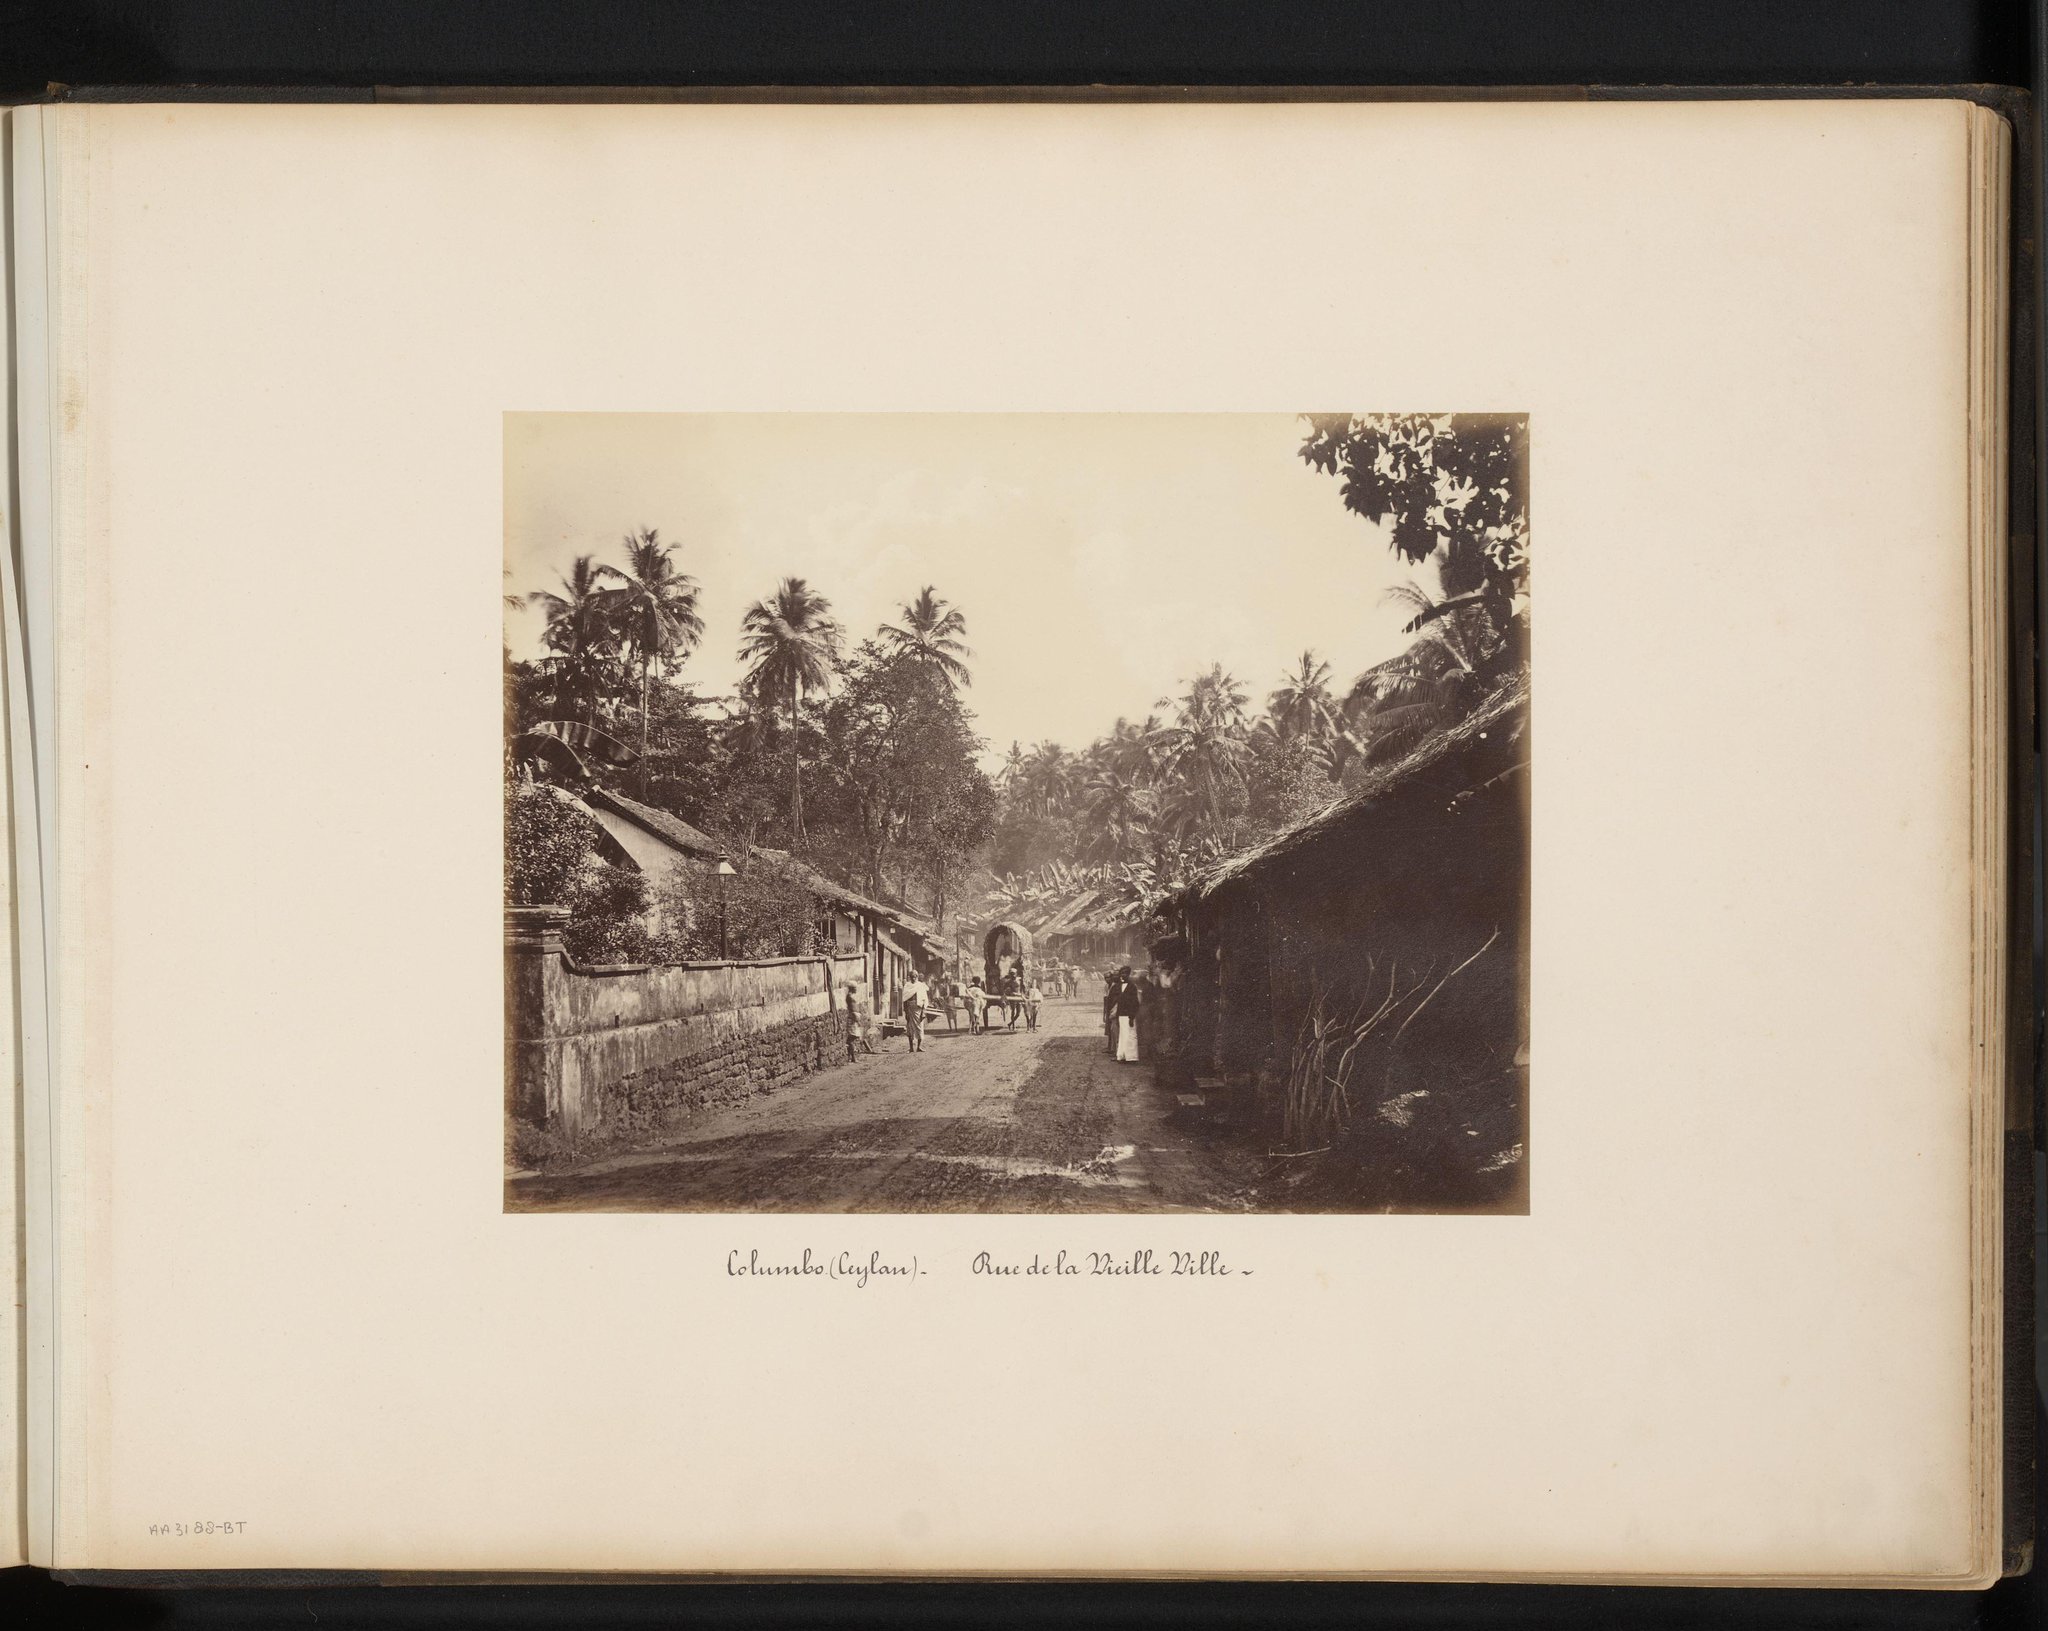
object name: photograph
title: Street view in Colombo, Sri Lanka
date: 1880-1883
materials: photographic support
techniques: albumen print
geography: colombo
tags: street (+ city(-scape) with figures, staffage)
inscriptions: title: ‘Columbo. (Ceylan) _ Rue de la Vieille Ville _’, inscription: ‘Photographers/ W.L.H. Skeen & Co./ Colombo. Ceylon’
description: Onderdeel van Reisalbum met opnames van bezienswaardigheden in Egypte, Nederlands-Indië, Singapore en Ceylon.